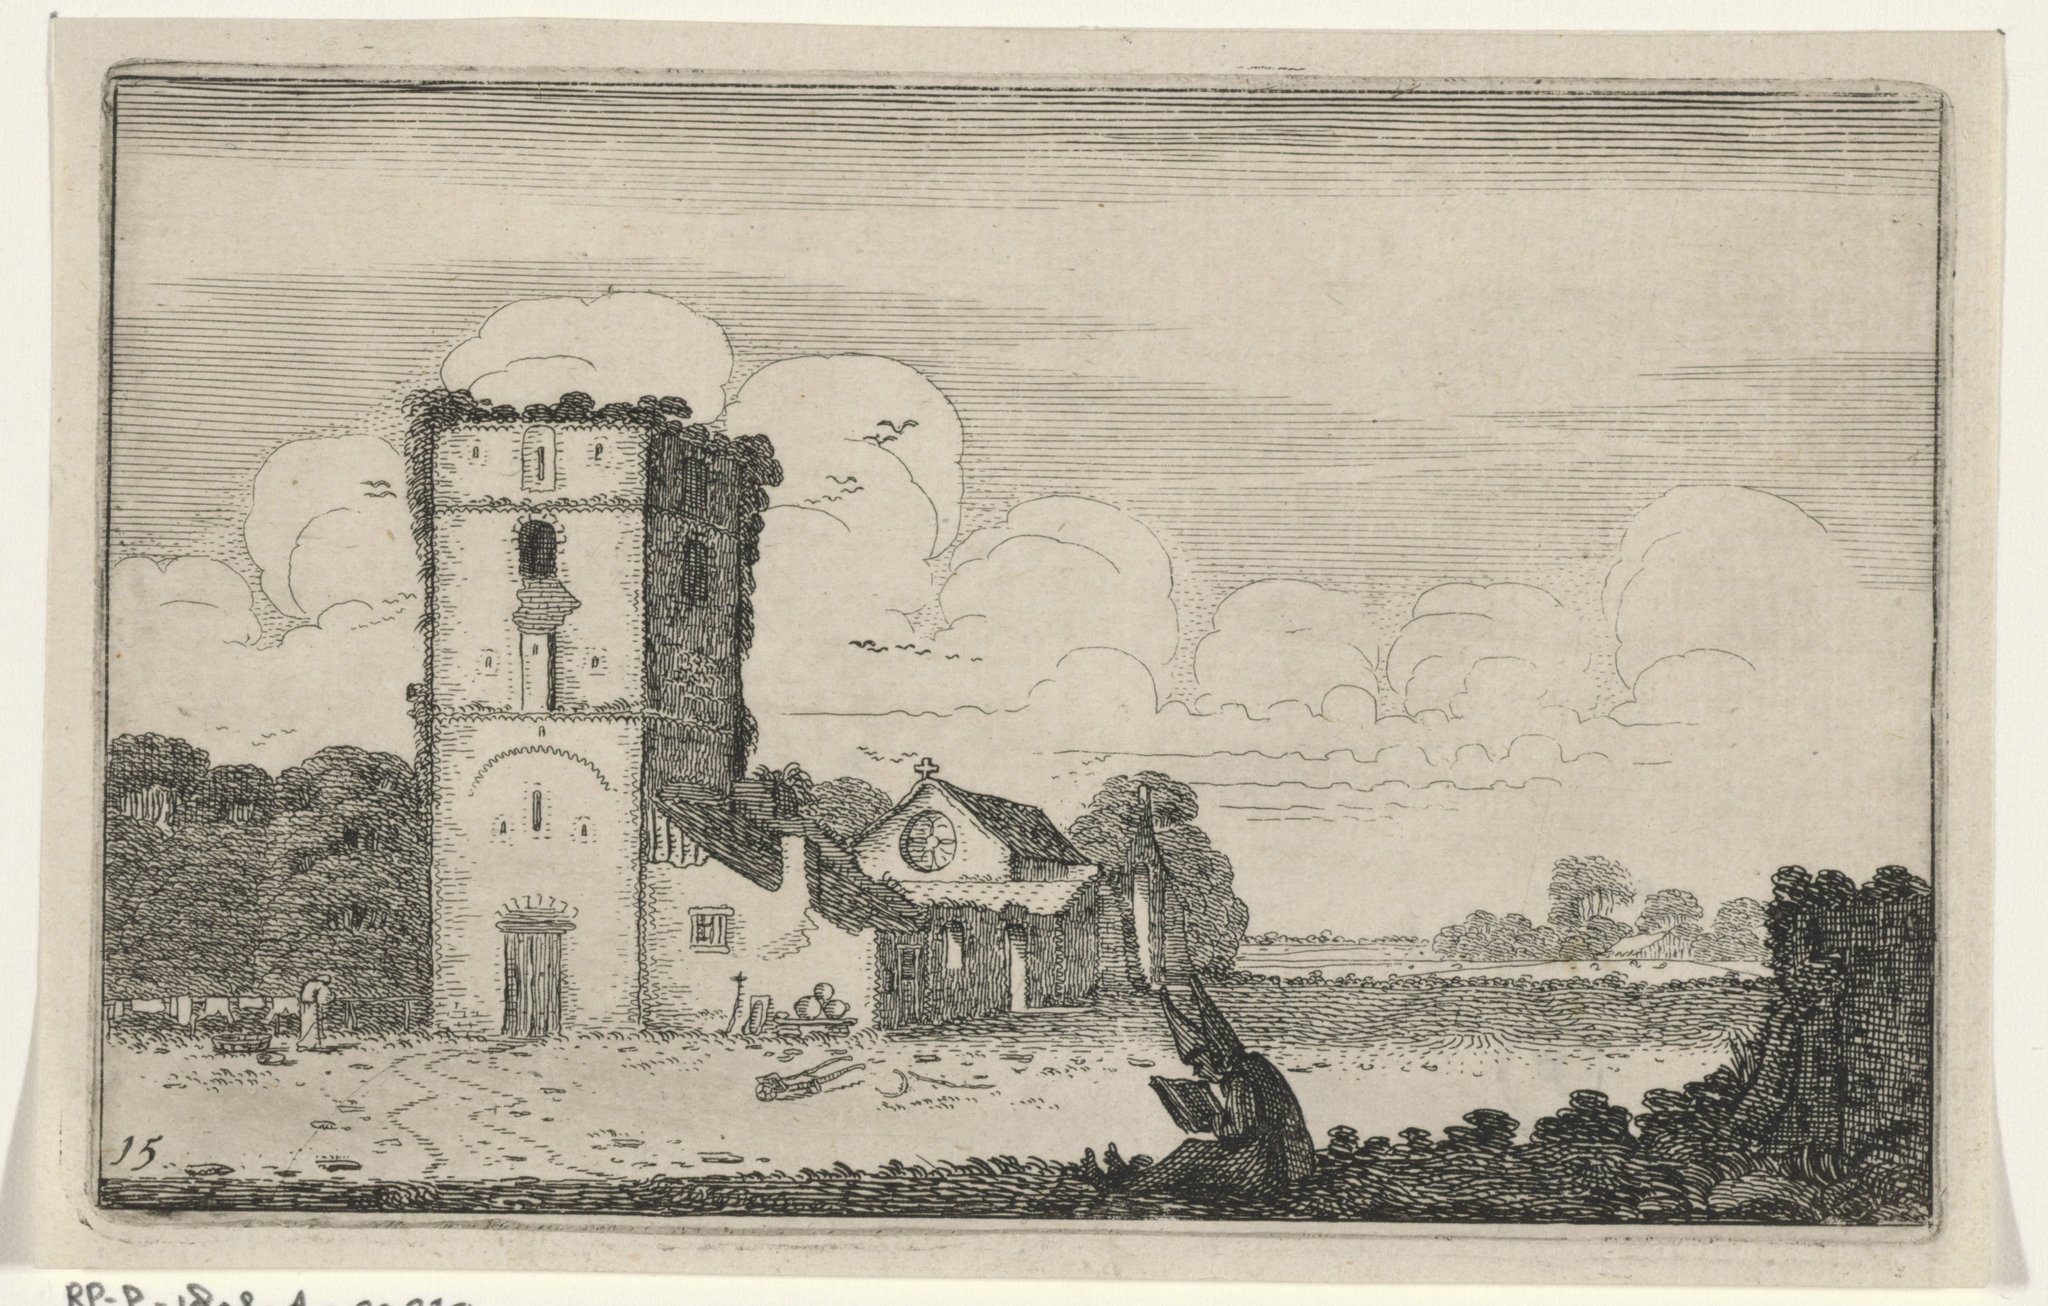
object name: print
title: Regiunculae quoddam amenae ruin aeque anti quidres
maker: jan van de velde (ii)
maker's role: draughtsman, painter, print maker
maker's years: 1593-1641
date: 1616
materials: paper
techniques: engraving, etching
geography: northern netherlands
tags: landscape with ruins, ruin of church, monastery, etc.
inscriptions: collector's mark: Lugt 964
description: Een vervallen kerk in een landschap, met op de voorgrond twee zittende lezende kloosterlingen. Vijftiende prent uit een serie van twintig.